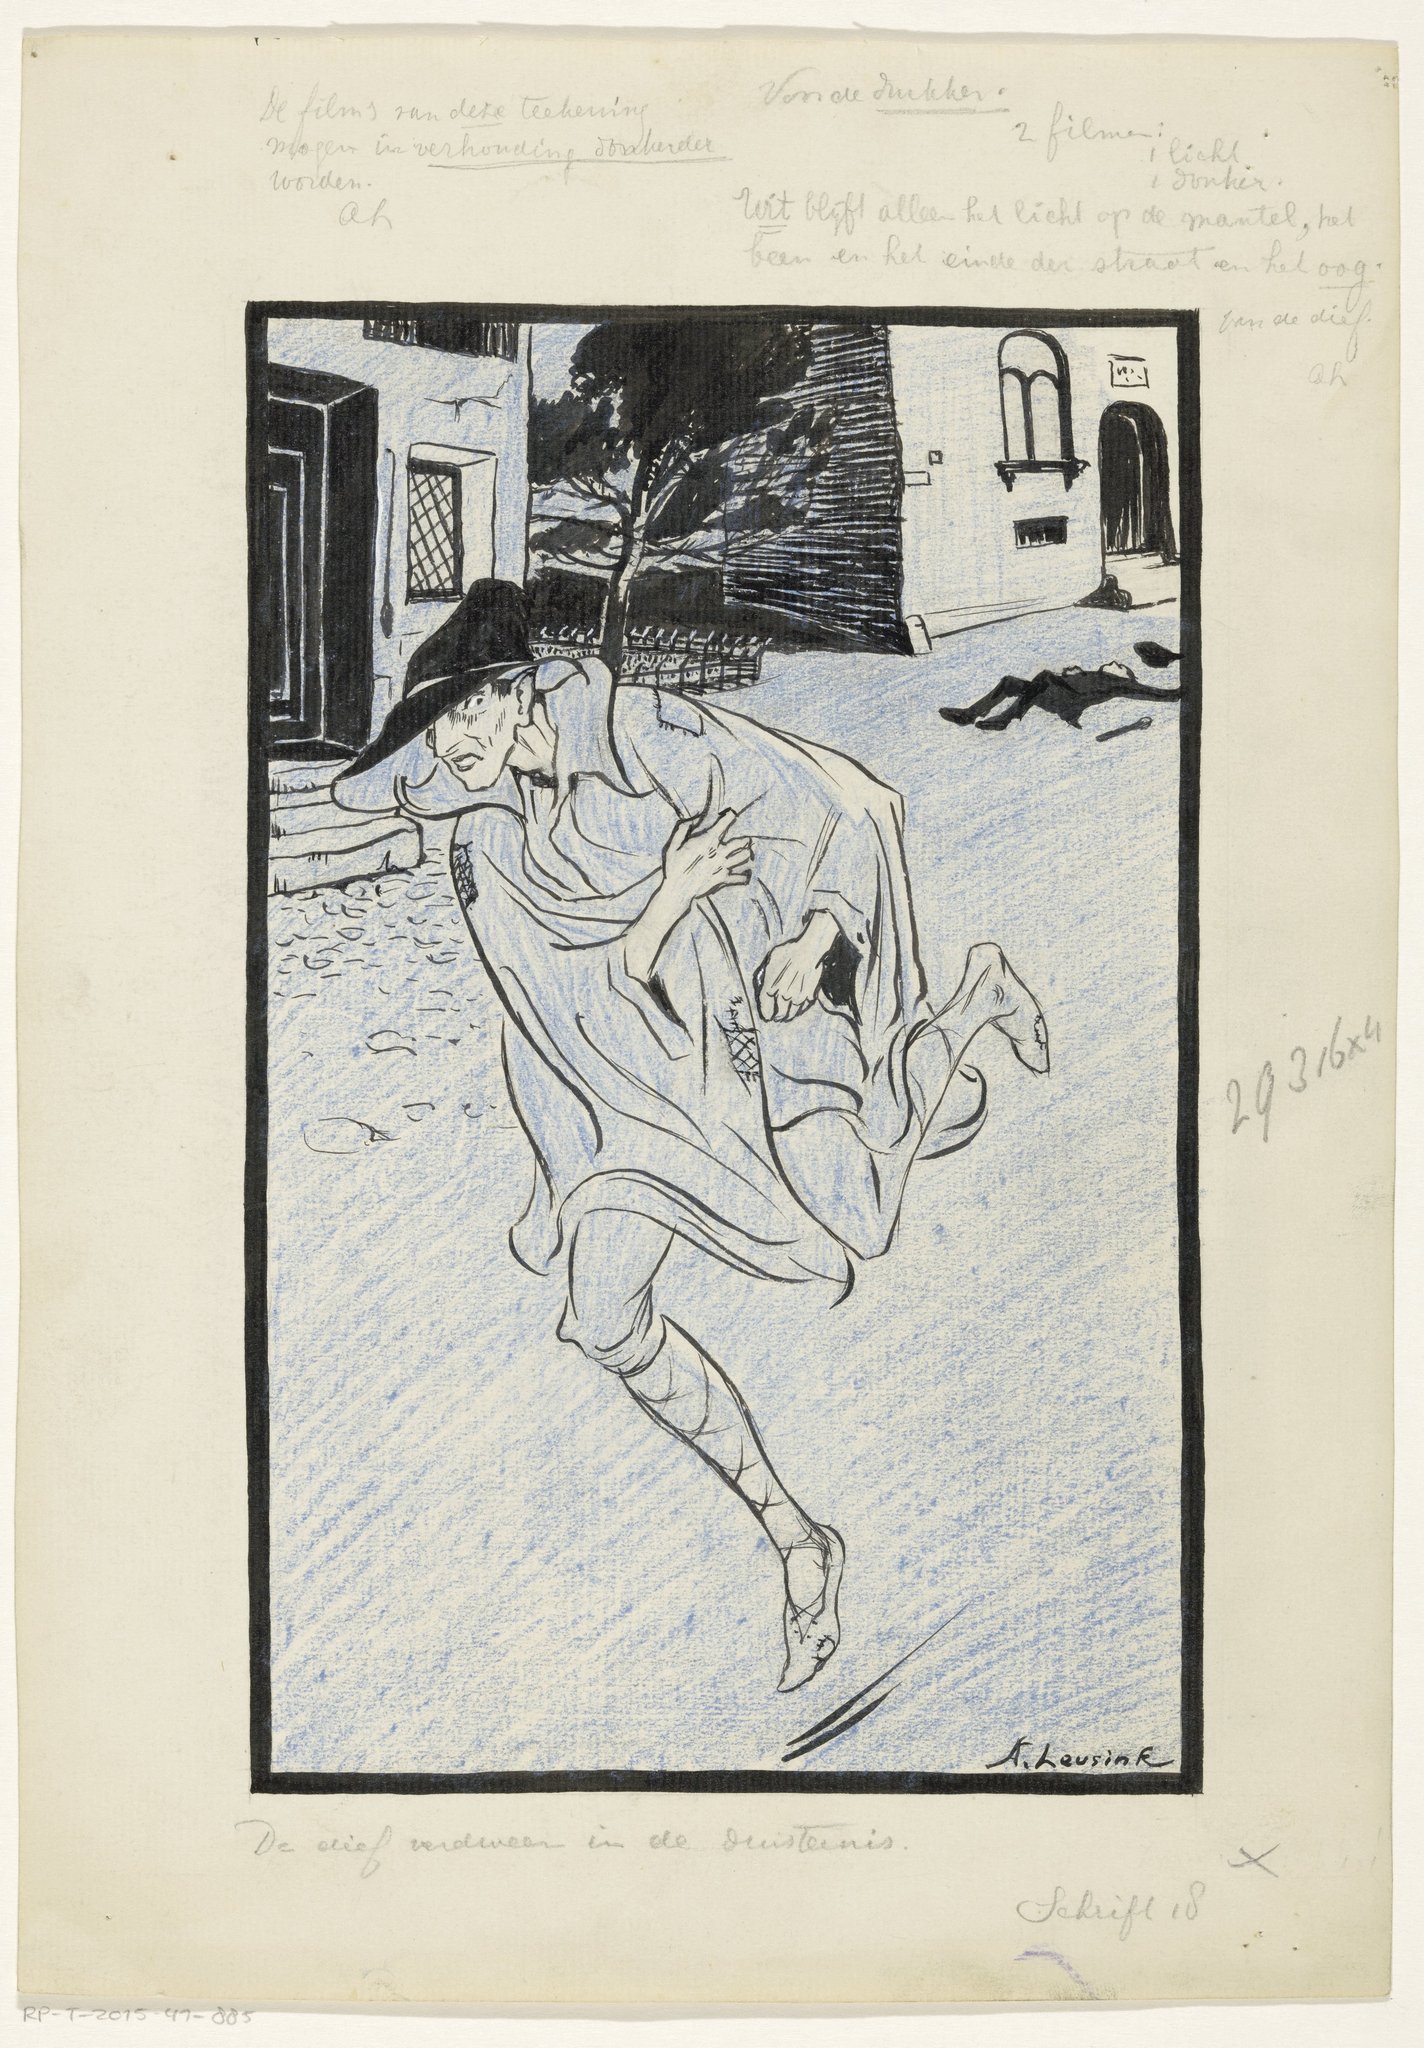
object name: drawing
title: Vluchtende dief in de duisternis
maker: anny leusink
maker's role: draughtsman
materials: paint, ink, paper, pencil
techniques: brush, pen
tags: flight, running away; pursuing, thief, darkness, street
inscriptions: :, annotation: ‘De dief verdween in de duisternis./ Schrift 18’, signature: ‘A. Leusink’, collector's mark: Lugt 2228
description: Een man gehuld in een versleten mantel met kap rent door een straat in de duisternis. Hij houdt met zijn hand zijn mantel gesloten. Op de achtergrond ligt een jongen op zijn rug op straat.